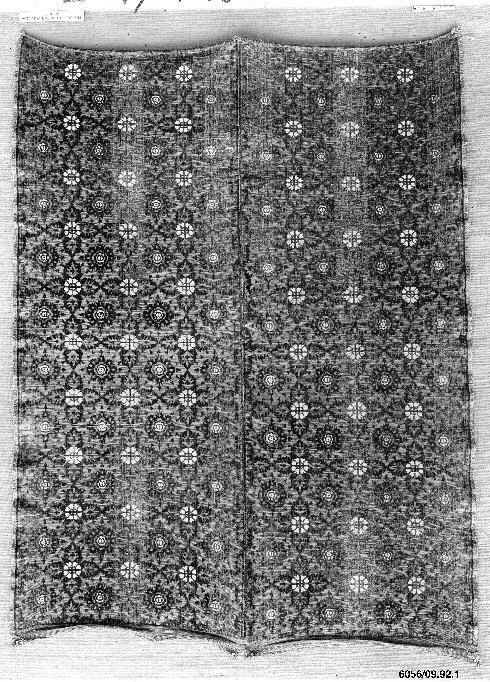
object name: cover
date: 1801-1900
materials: cotton, silk, velvet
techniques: cutting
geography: turkey